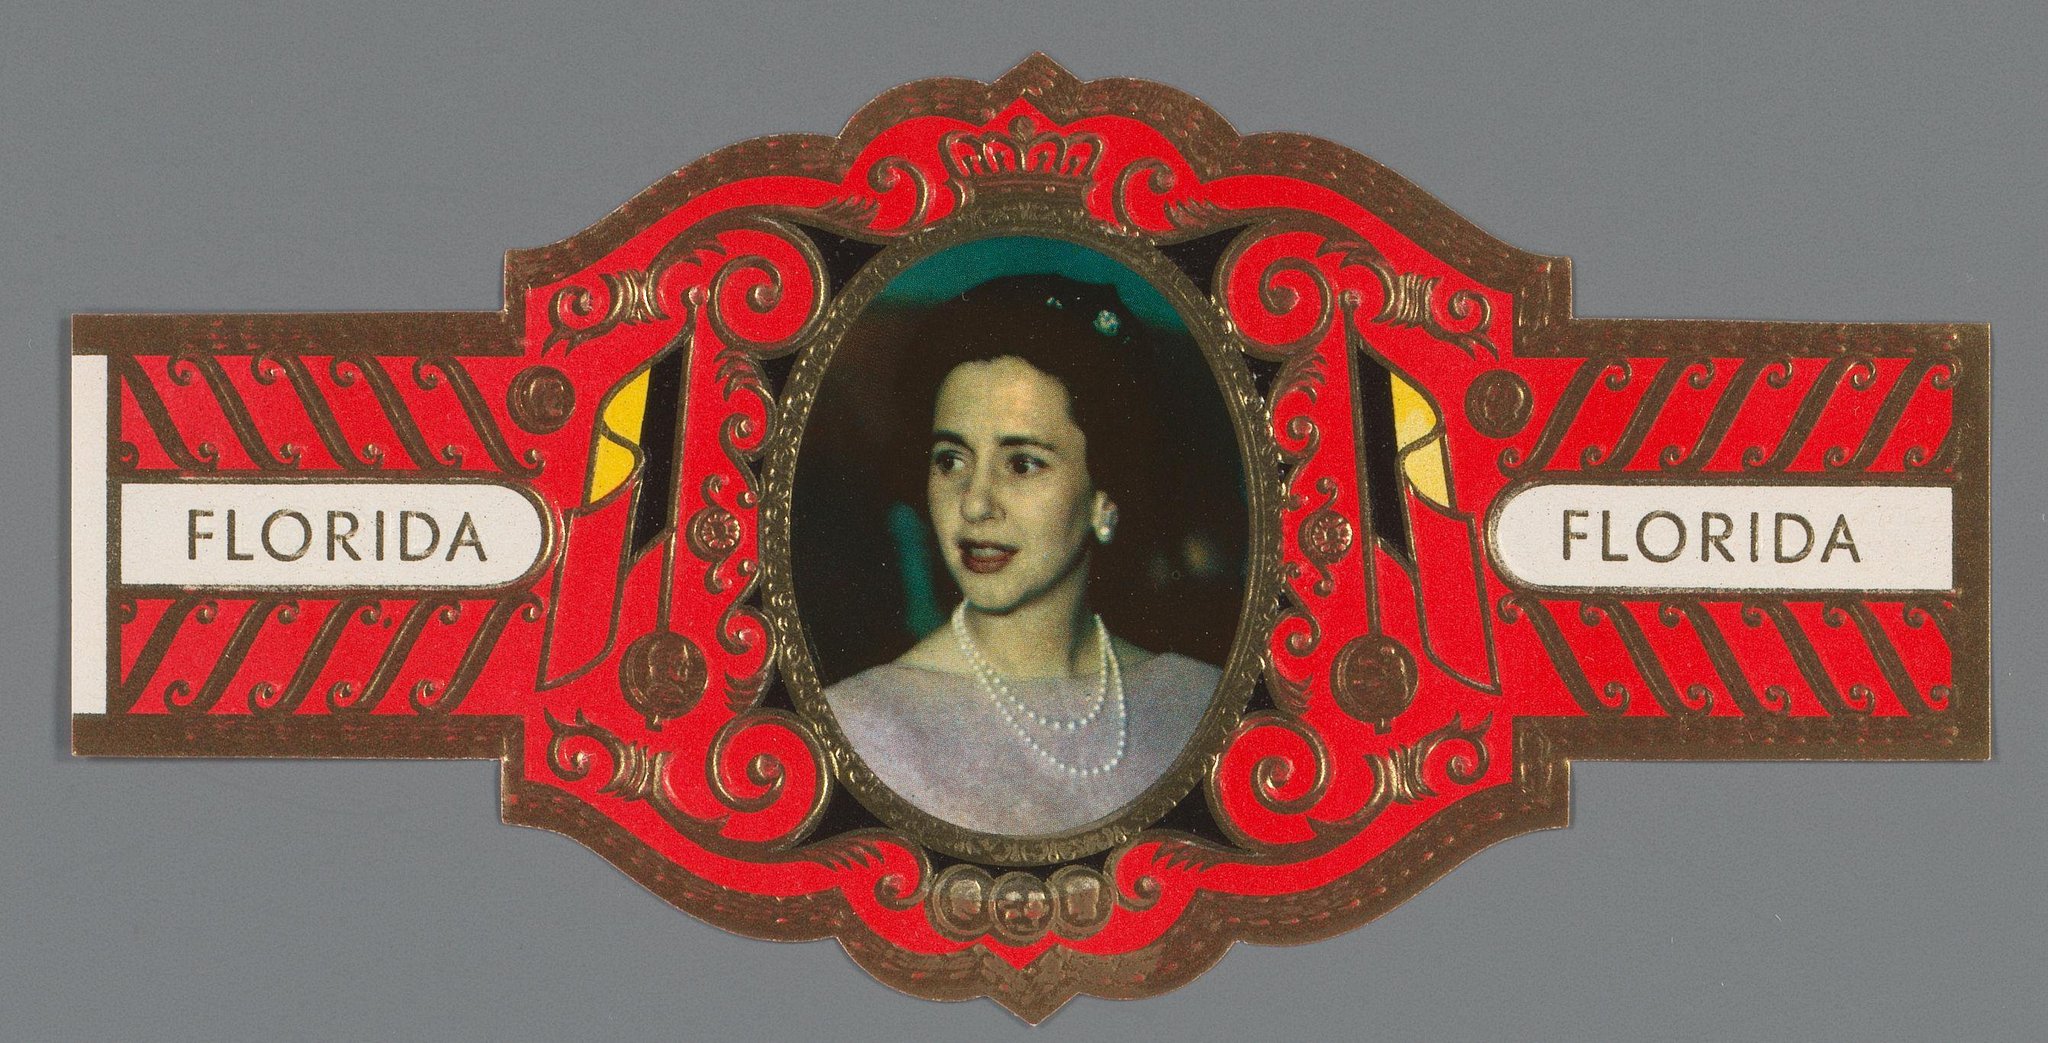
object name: cigar band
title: Portret van koningin Fabiola van België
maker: Anonymous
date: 1960-1975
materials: paper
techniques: blind stamped, printing block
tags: laeken, historical persons - bb - woman, queen, empress, etc. (wife of a ruler)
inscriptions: inscription: ‘Florida’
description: Aan weerszijden van het portret is tweemaal de vlag van het land afgebeeld.